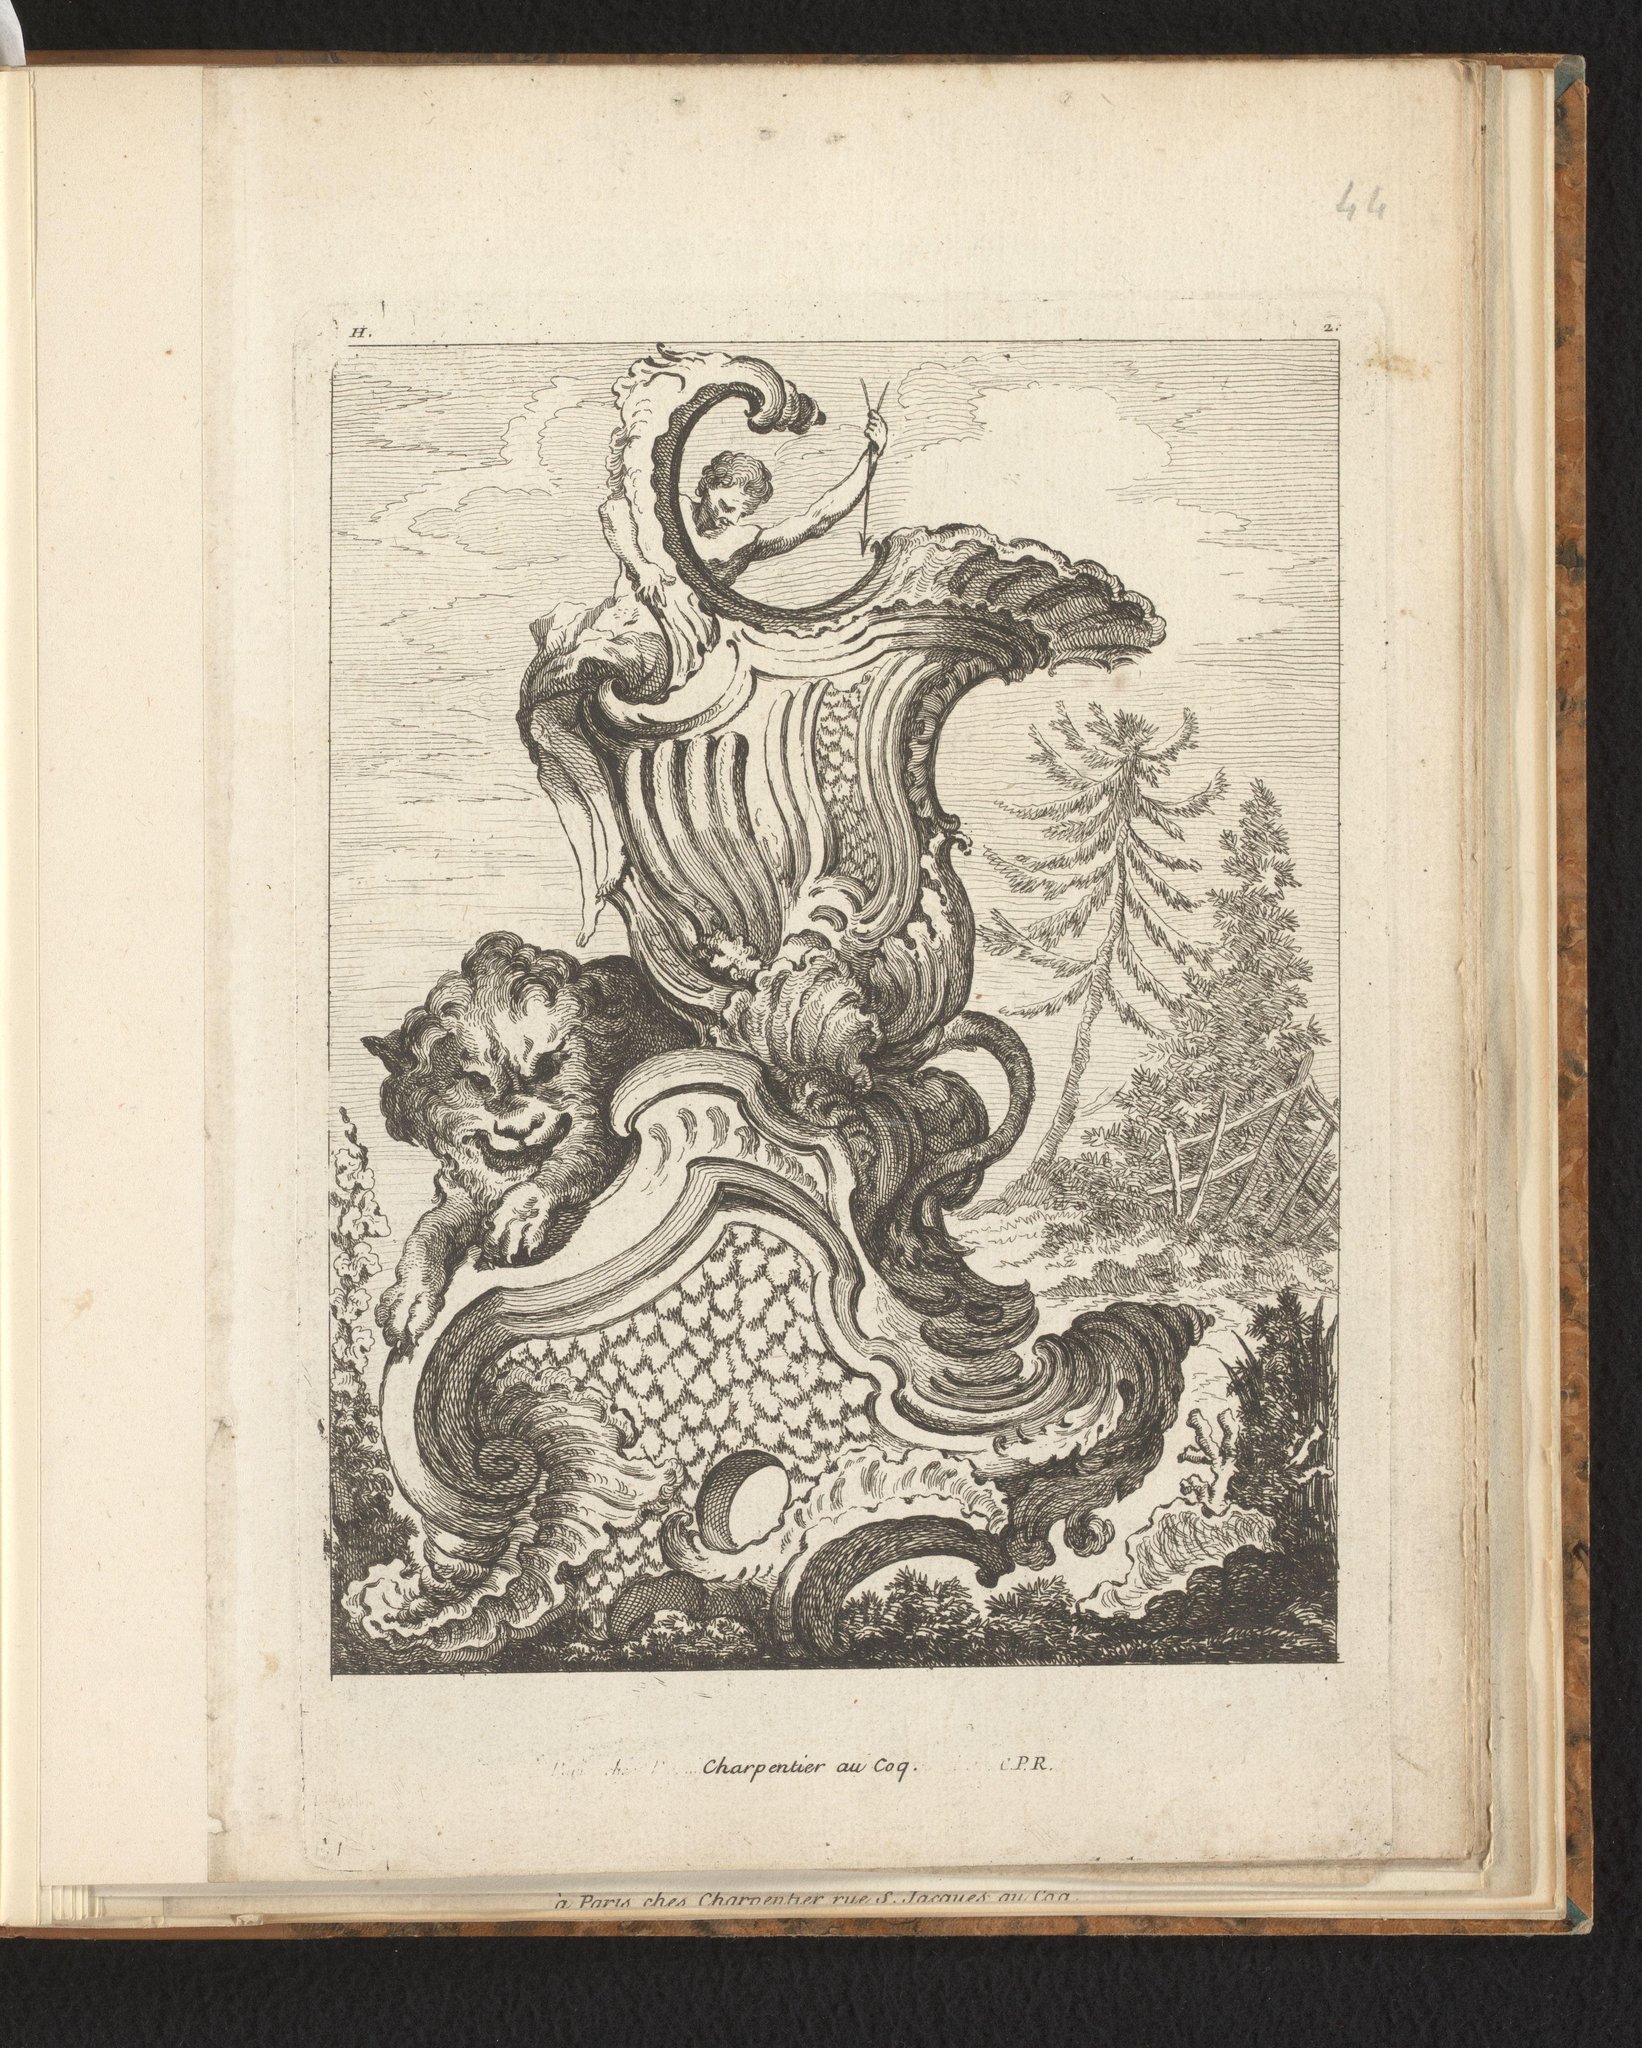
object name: ornament print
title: Rocaille met leeuw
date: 1736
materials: paper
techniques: engraving, etching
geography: paris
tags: rocaille ornament, beasts of prey, predatory animals: lion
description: Deze prent maakt deel uit van een serie en is linksboven genummerd met een letter H. Prent maakt deel uit van een album.